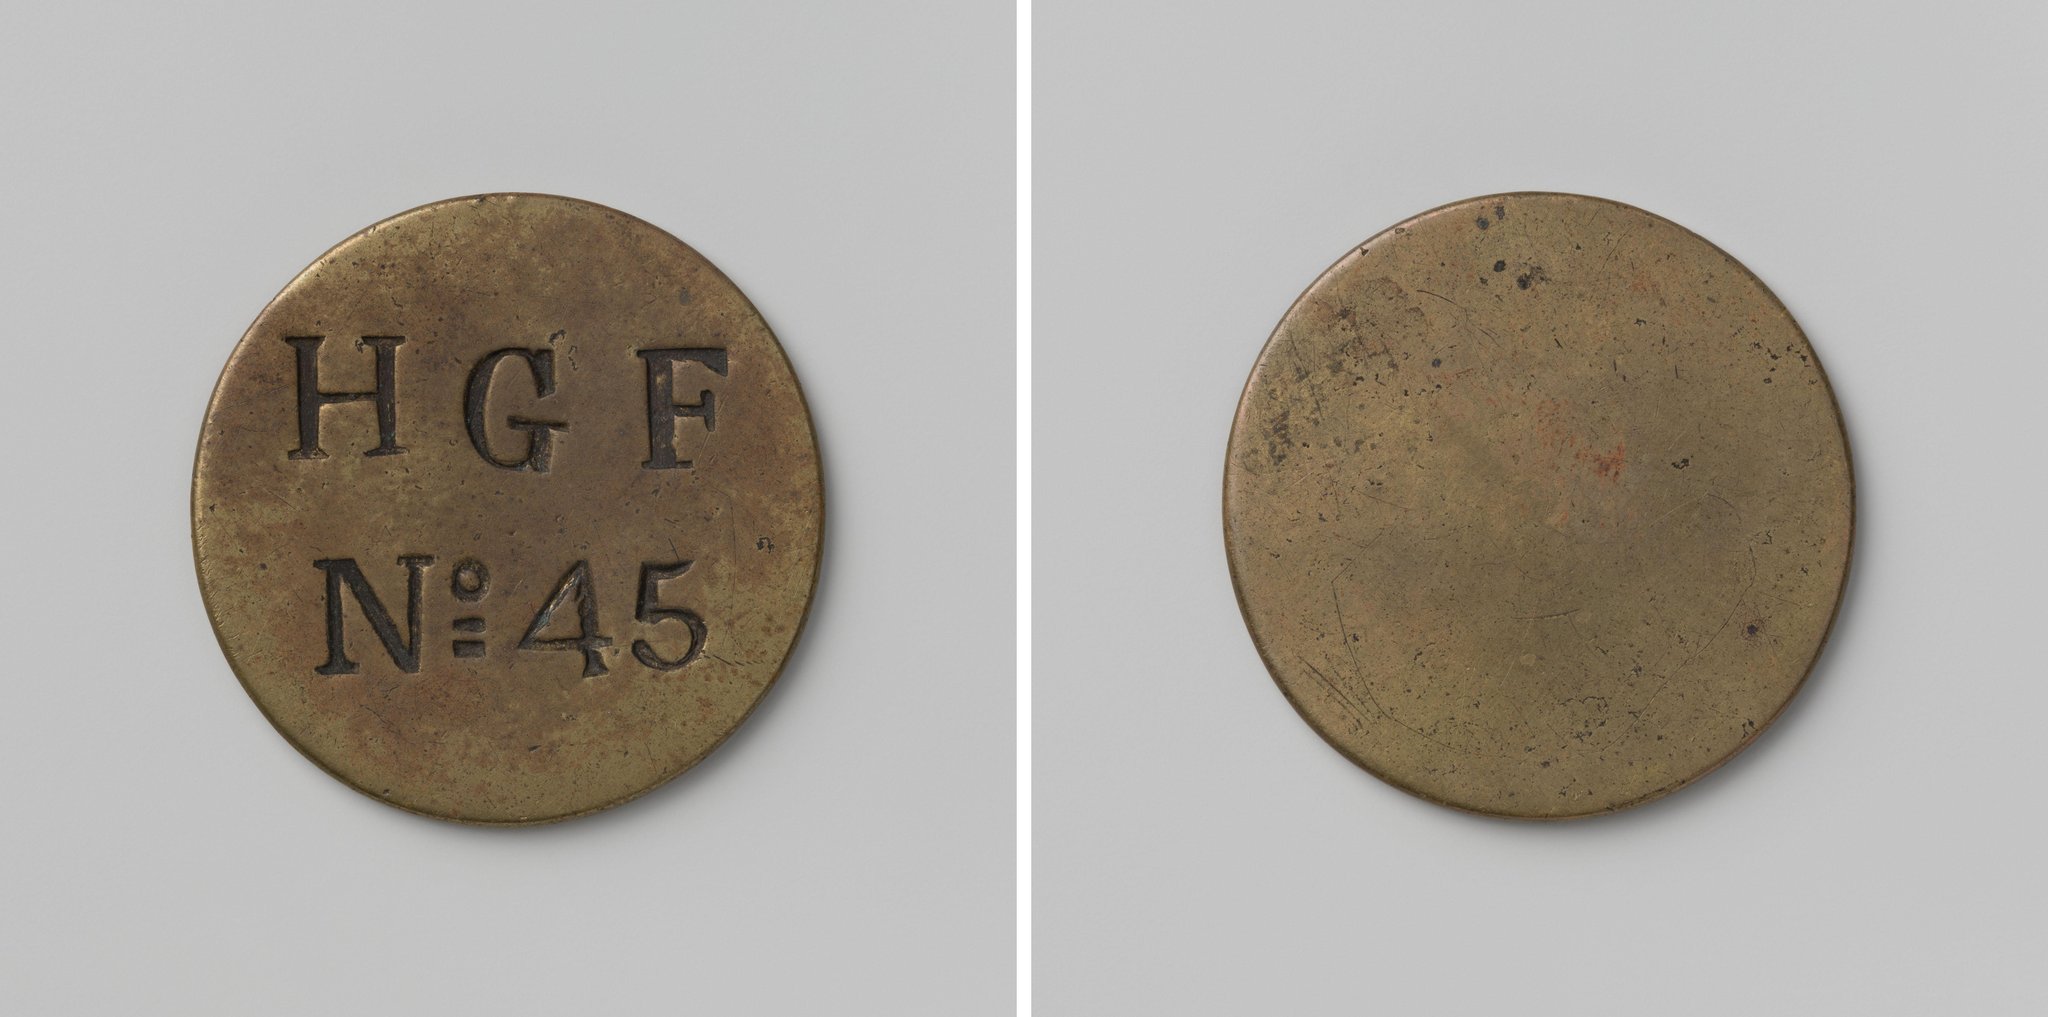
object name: fire engine medal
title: Brandspuitpenning met no. 45 en monogram H.G.F.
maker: Anonymous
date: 1800-1900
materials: brass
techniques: engraving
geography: netherlands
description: Eenzijdige messing penning. Voorzijde: opschrift H.G.F. boven opschrift No. 45. Keerzijde: blanco